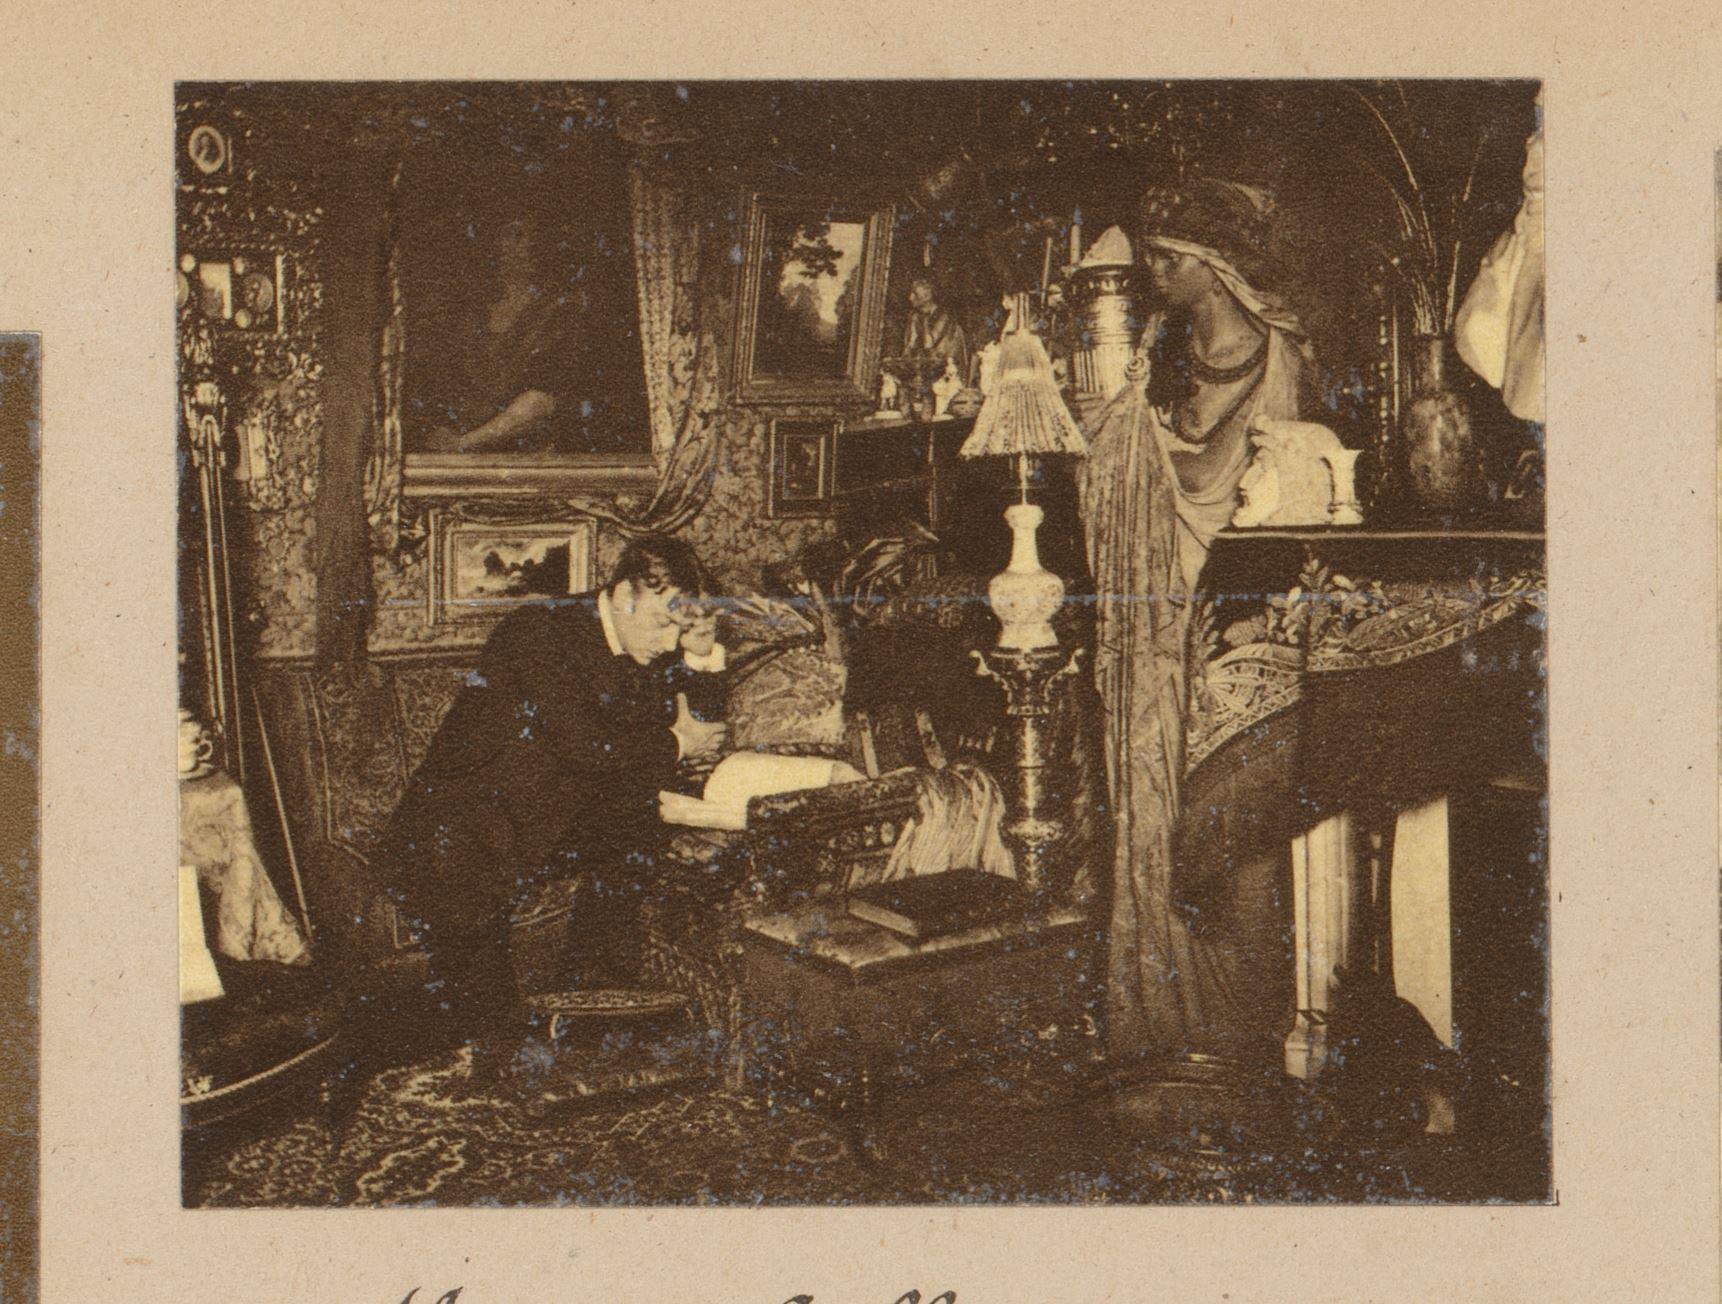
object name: photograph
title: Jean Mounet-Sully met een boek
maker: Anonymous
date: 1910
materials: paper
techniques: rotogravure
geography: france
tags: paris, portrait of actor, actress, france